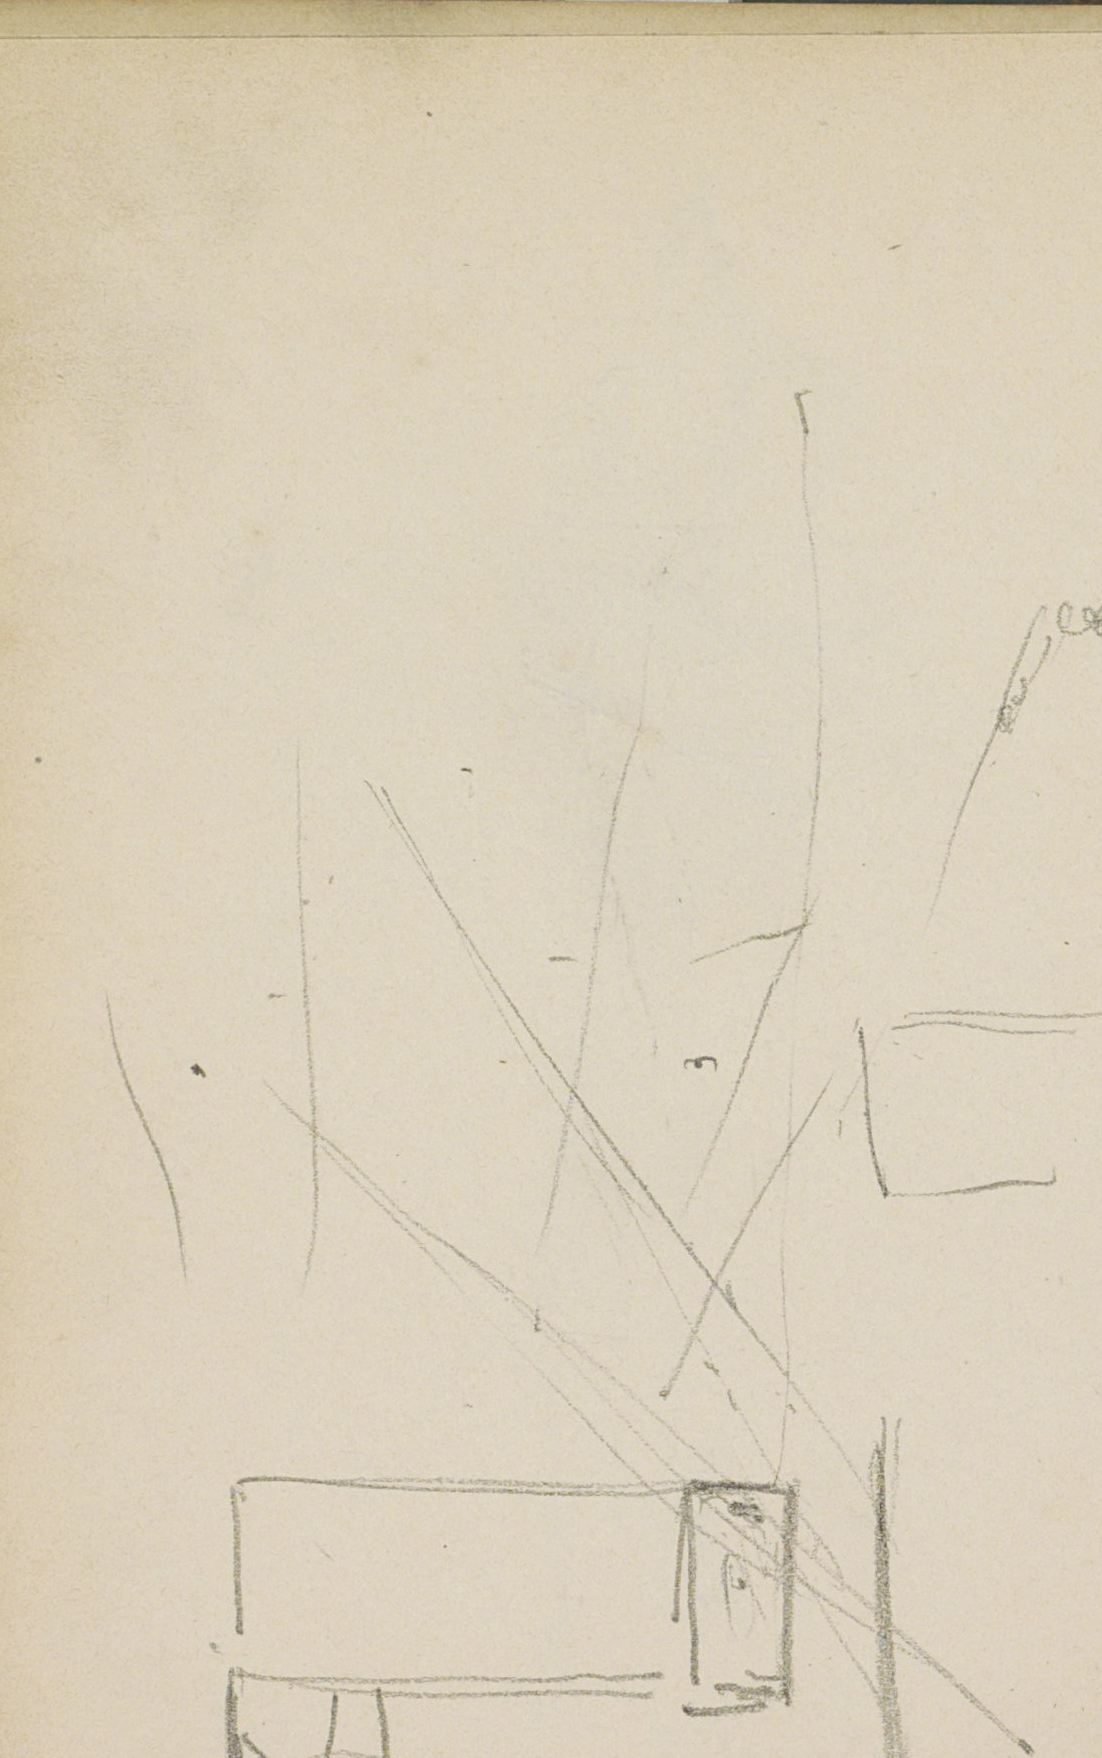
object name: sketchbook leaf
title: Studie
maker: johannes tavenraat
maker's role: draughtsman, painter, print maker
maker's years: 1809-1881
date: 1839-1872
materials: paper, pencil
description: Blad 13 verso uit een schetsboek met 73 bladen.